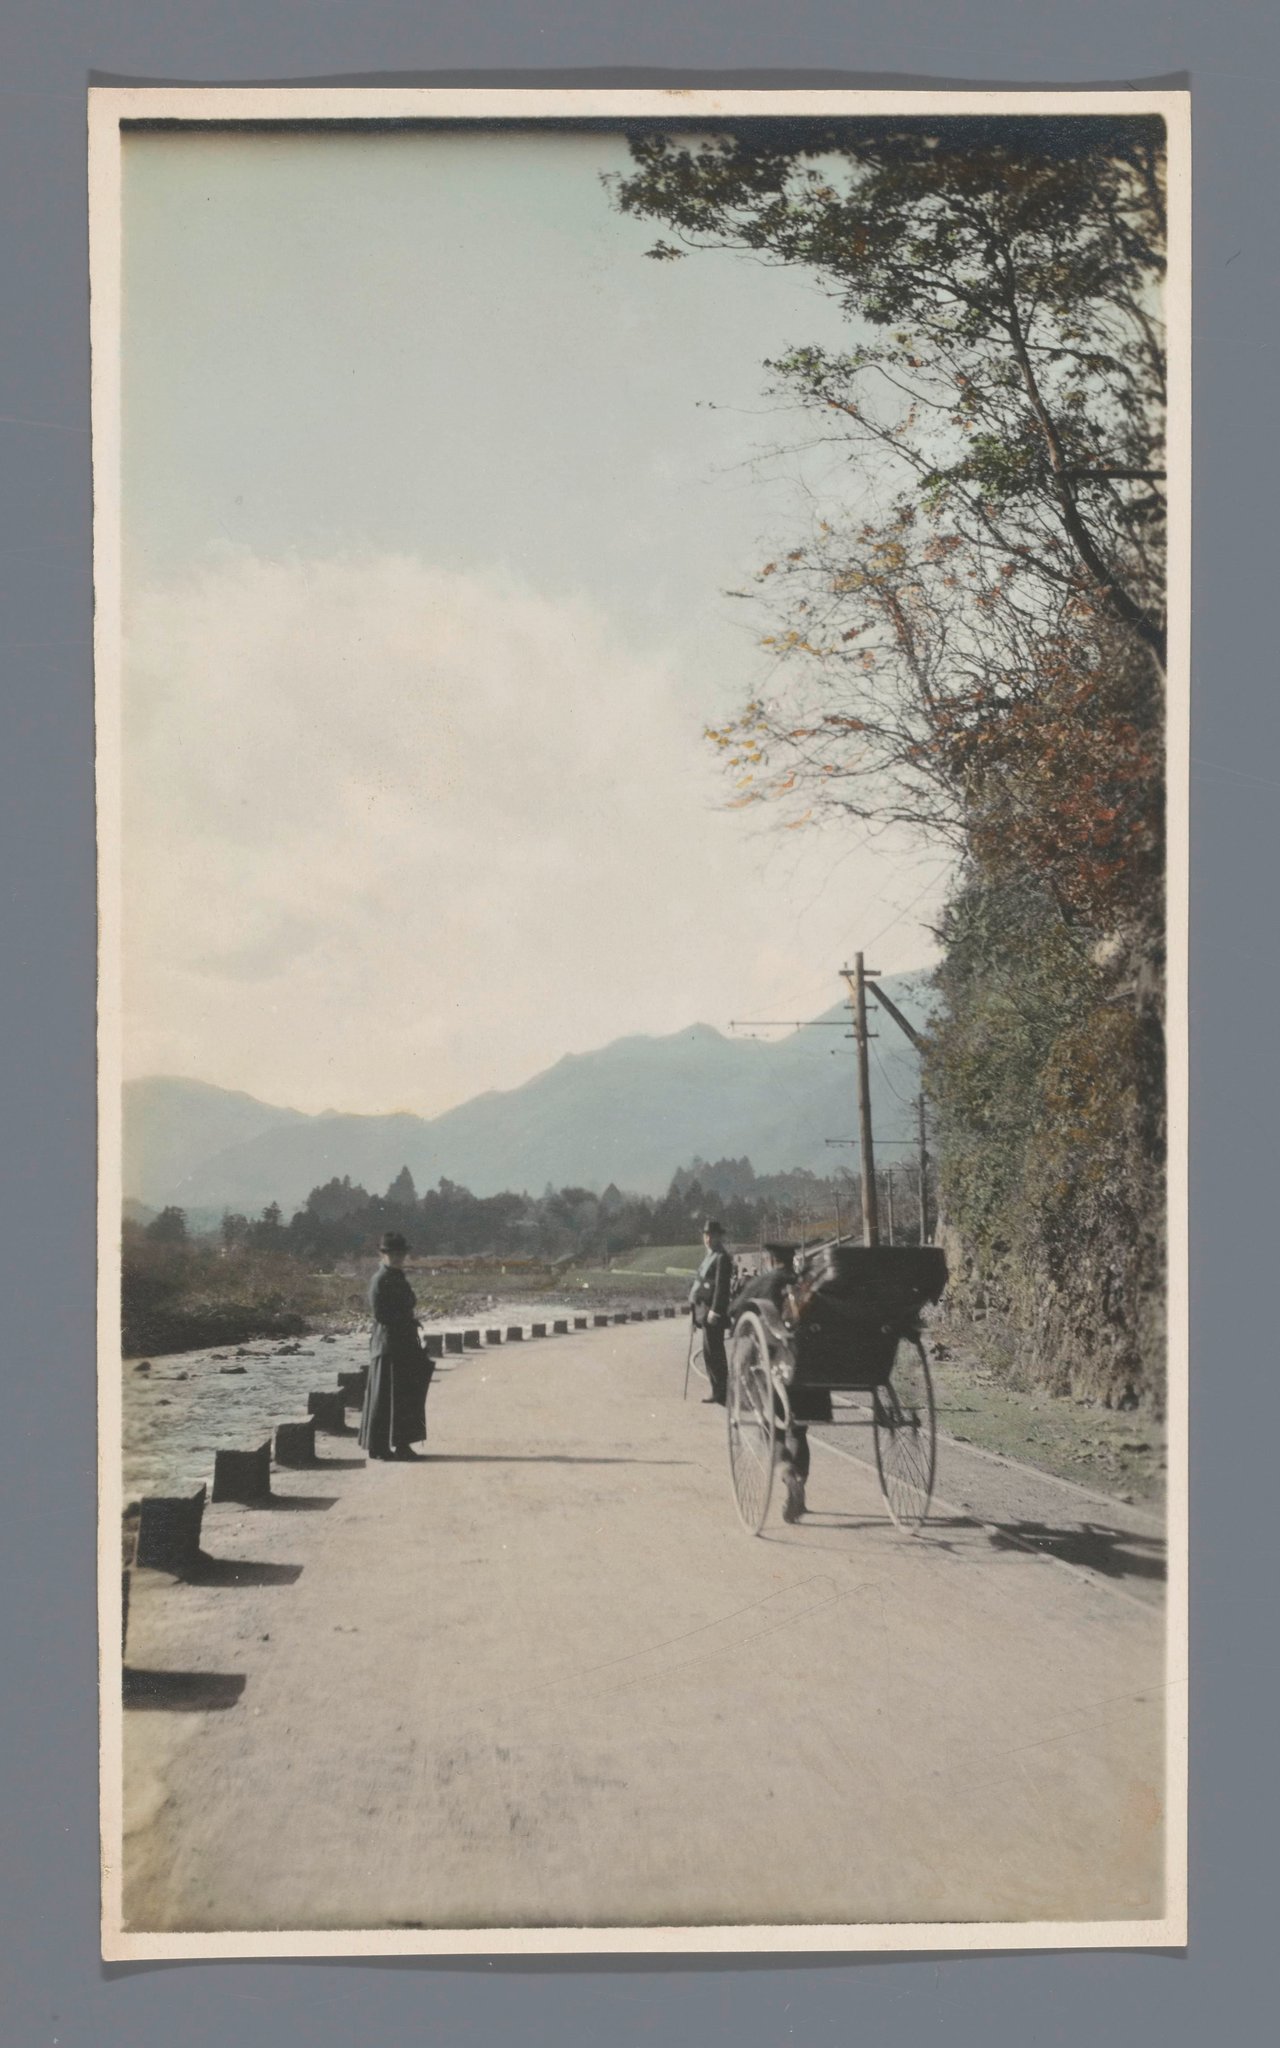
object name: photograph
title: Een man en een vrouw met een voorbijgaande riksjah (fietstaxi) op een weg langs een rivier, Japan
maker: jan adriani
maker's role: fotograaf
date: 1917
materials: paper, photographic support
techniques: gelatin silver print, hand coloring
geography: japan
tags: river, japan